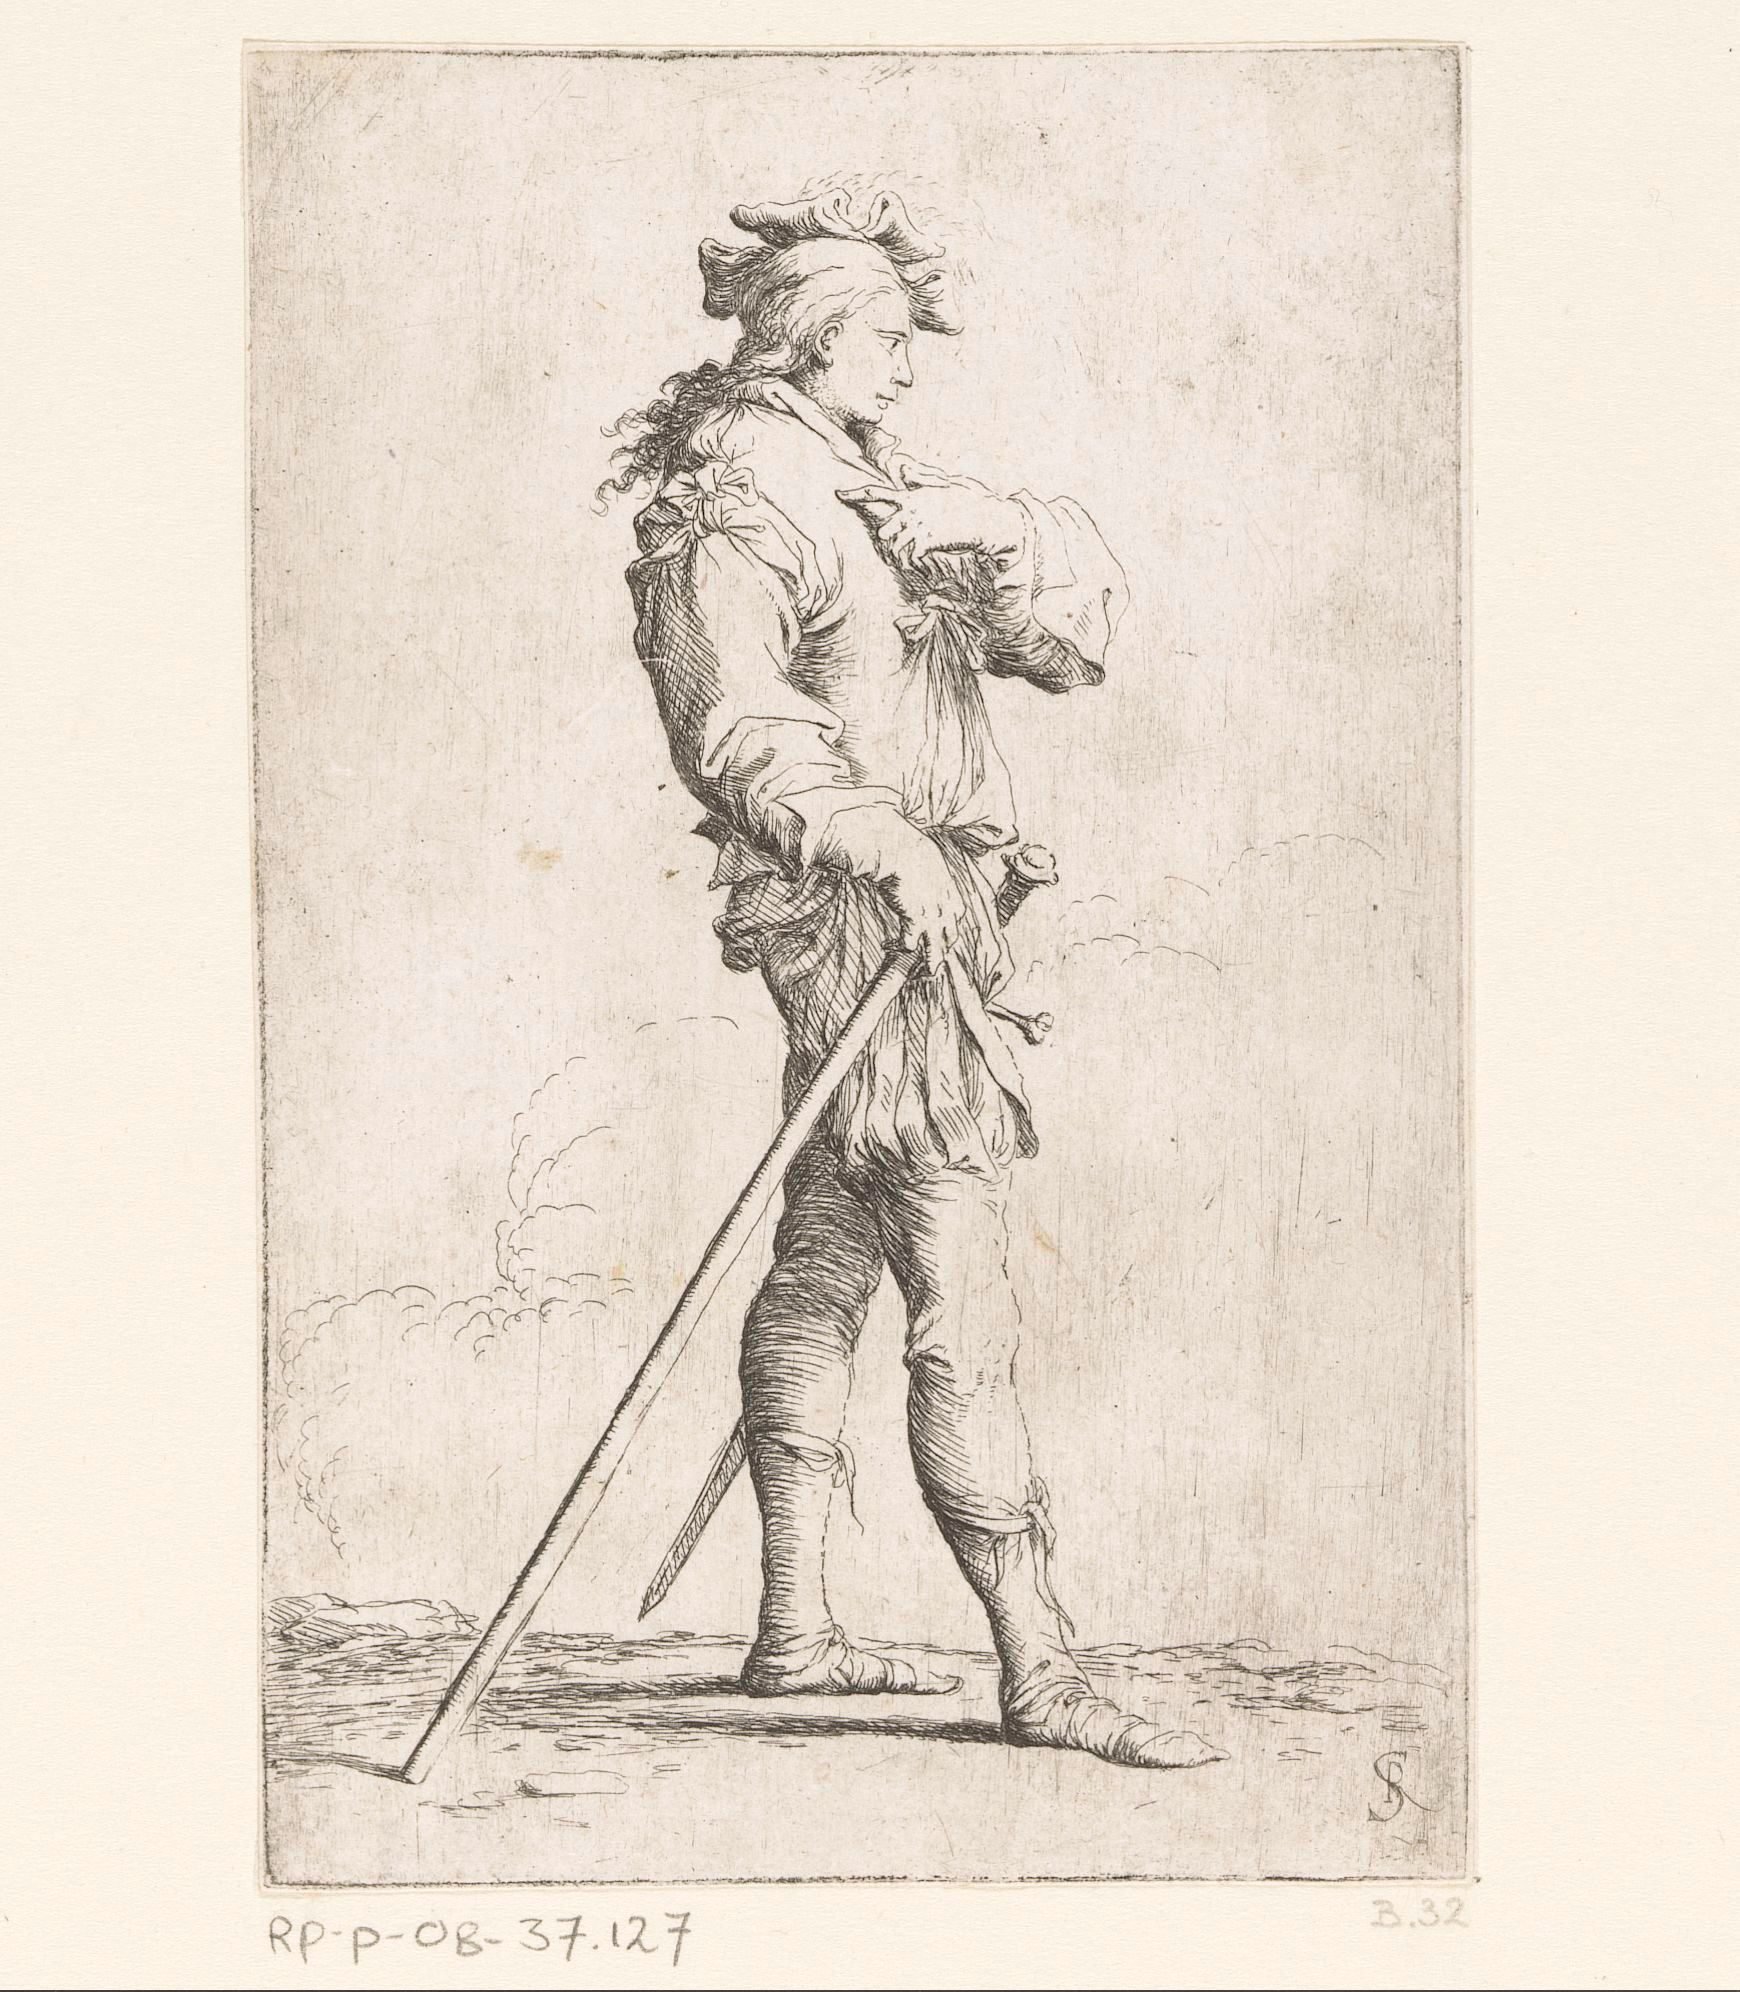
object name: print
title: Kleine figuren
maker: salvator rosa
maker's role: draughtsman, painter, print maker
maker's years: 1615-1673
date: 1656-1657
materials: paper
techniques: drypoint, etching, intaglio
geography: italy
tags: walking-stick, staff, hacking and thrusting weapons: sword, the soldier; the soldier's life, index finger forwards, pointing, indicating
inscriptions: number: ‘36’, collector's mark: Lugt 240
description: Prent spiegelbeeldig naar een tekening in het British Museum te Londen (inv.nr. Ff,2.168). Deze prent maakt deel uit van de serie 'Figurine', bestaande uit een titelprent en 80 prenten van klein formaat met voorstellingen van mannelijke en vrouwelijke figuren. Rosa produceerde de serie waarschijnlijk gedurende de jaren 1656 en 1657.